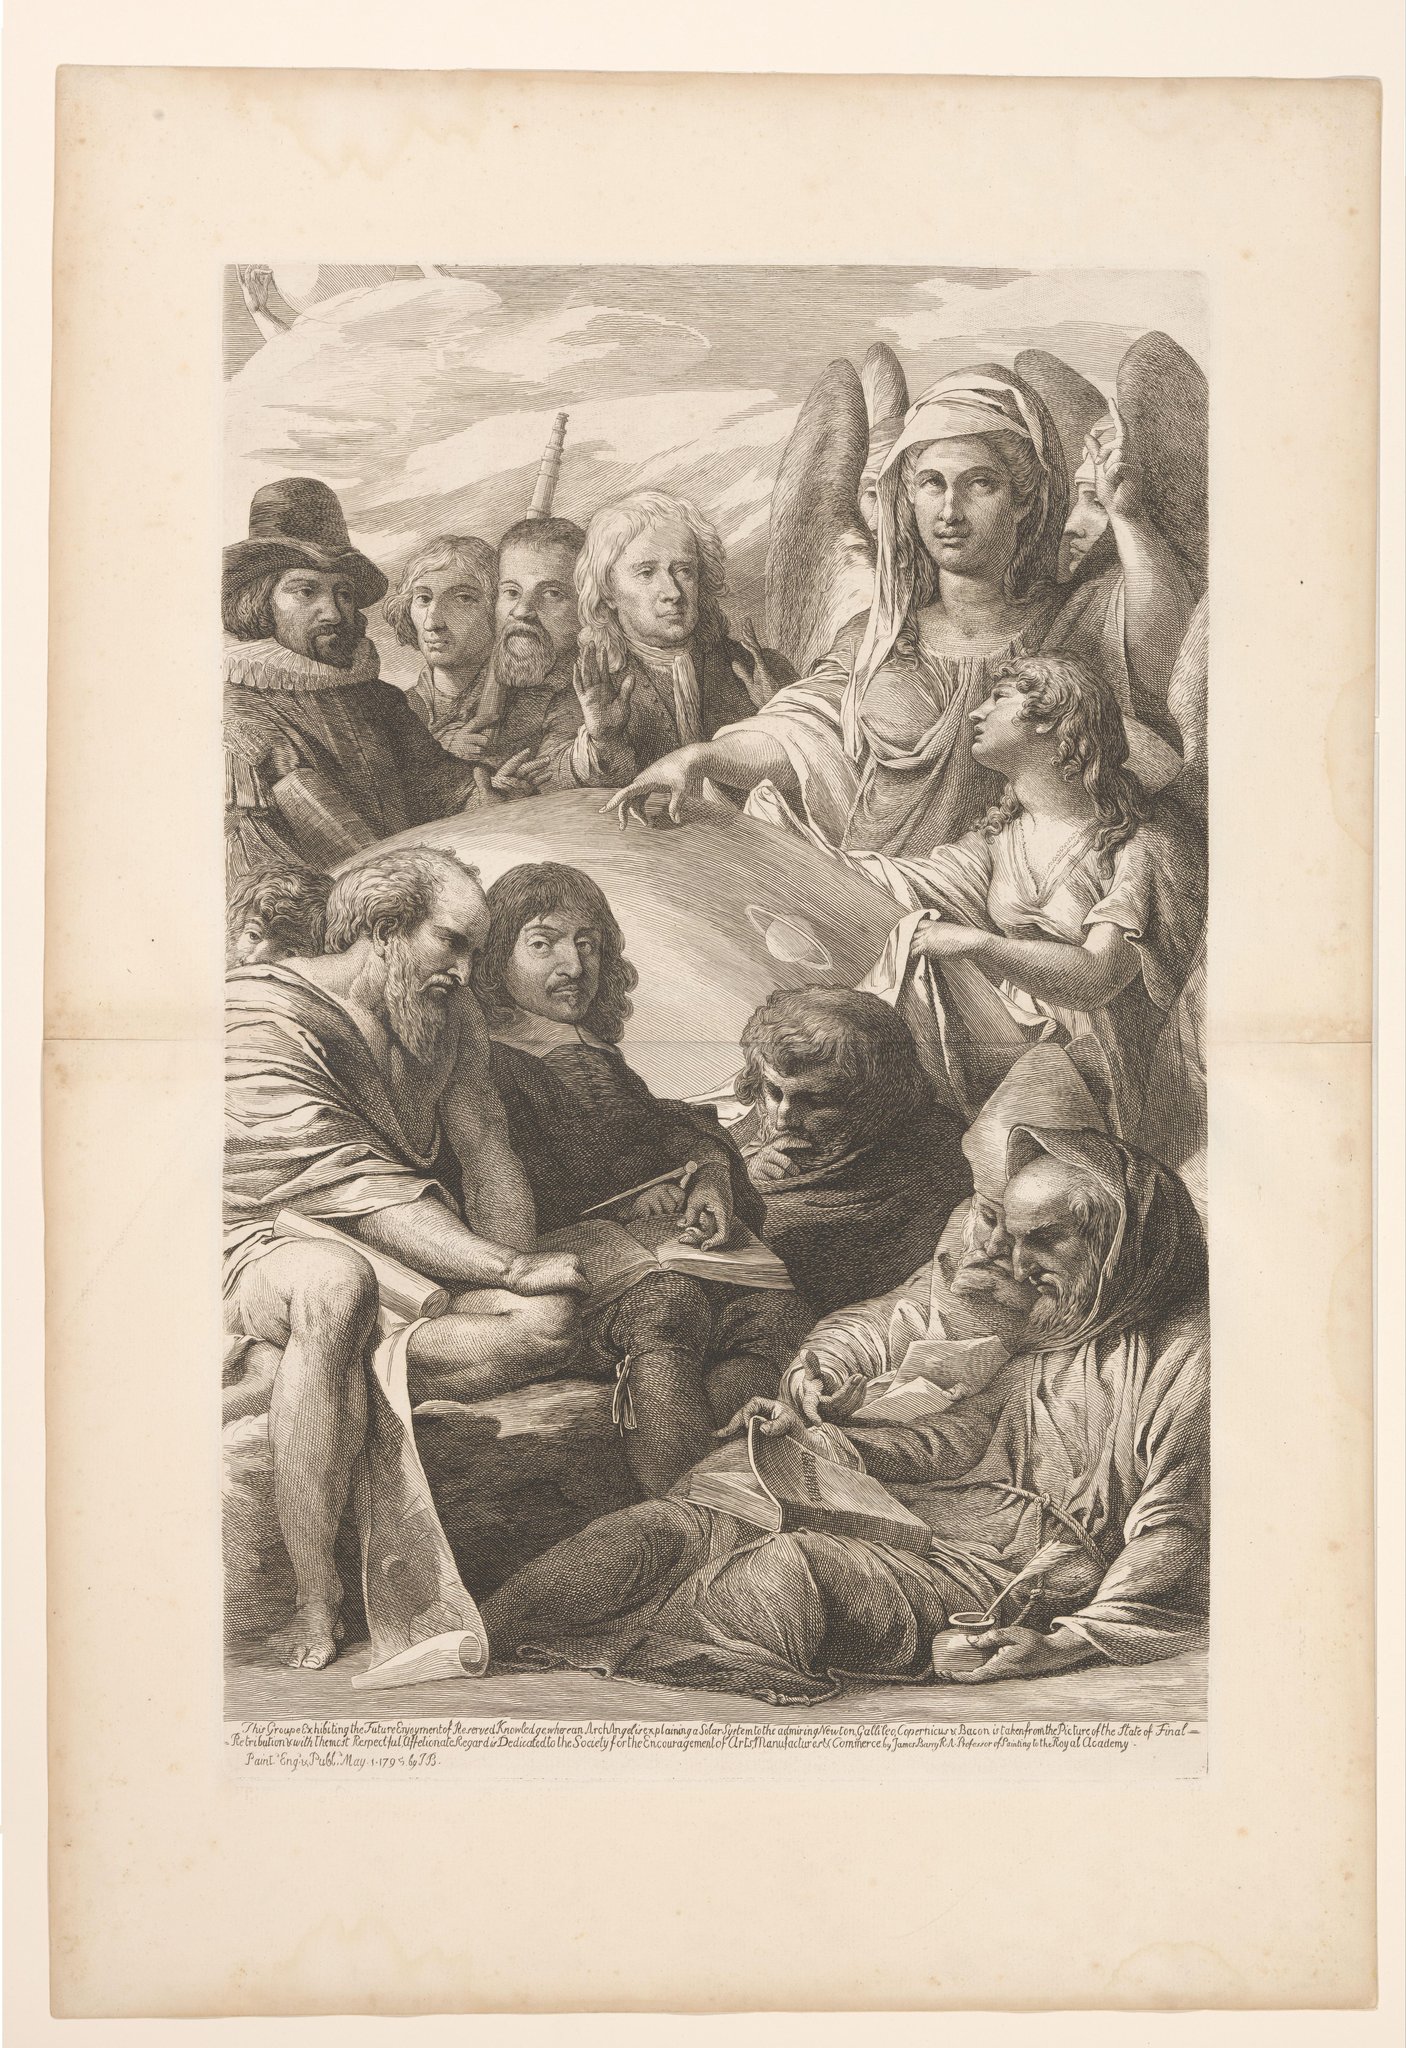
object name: print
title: Voorbehouden kennis (allegorie op de wetenschap)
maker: james barry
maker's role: draughtsman, print maker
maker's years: 1741-1806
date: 1795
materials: paper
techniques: engraving, etching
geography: london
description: Een aartsengel legt het zonnestelsel uit aan een groep wetenschappers. Van links naar rechts in de bovenste zone zijn voorgesteld de natuurkundigen: Francis Bacon, Nicolaas Copernicus, Galileo Galilei en Isaac Newton. In de onderste zone van links naar rechts zijn zittend voorgesteld de filosofen Thales van Milete en René Descartes, de wiskundige Archimedes, de theoloog Robert Grosseteste en de Franciscaan en natuurwetenschapper Roger Bacon. In het midden van de groep bevindt zich een hemelglobe met de planeet Jupiter.